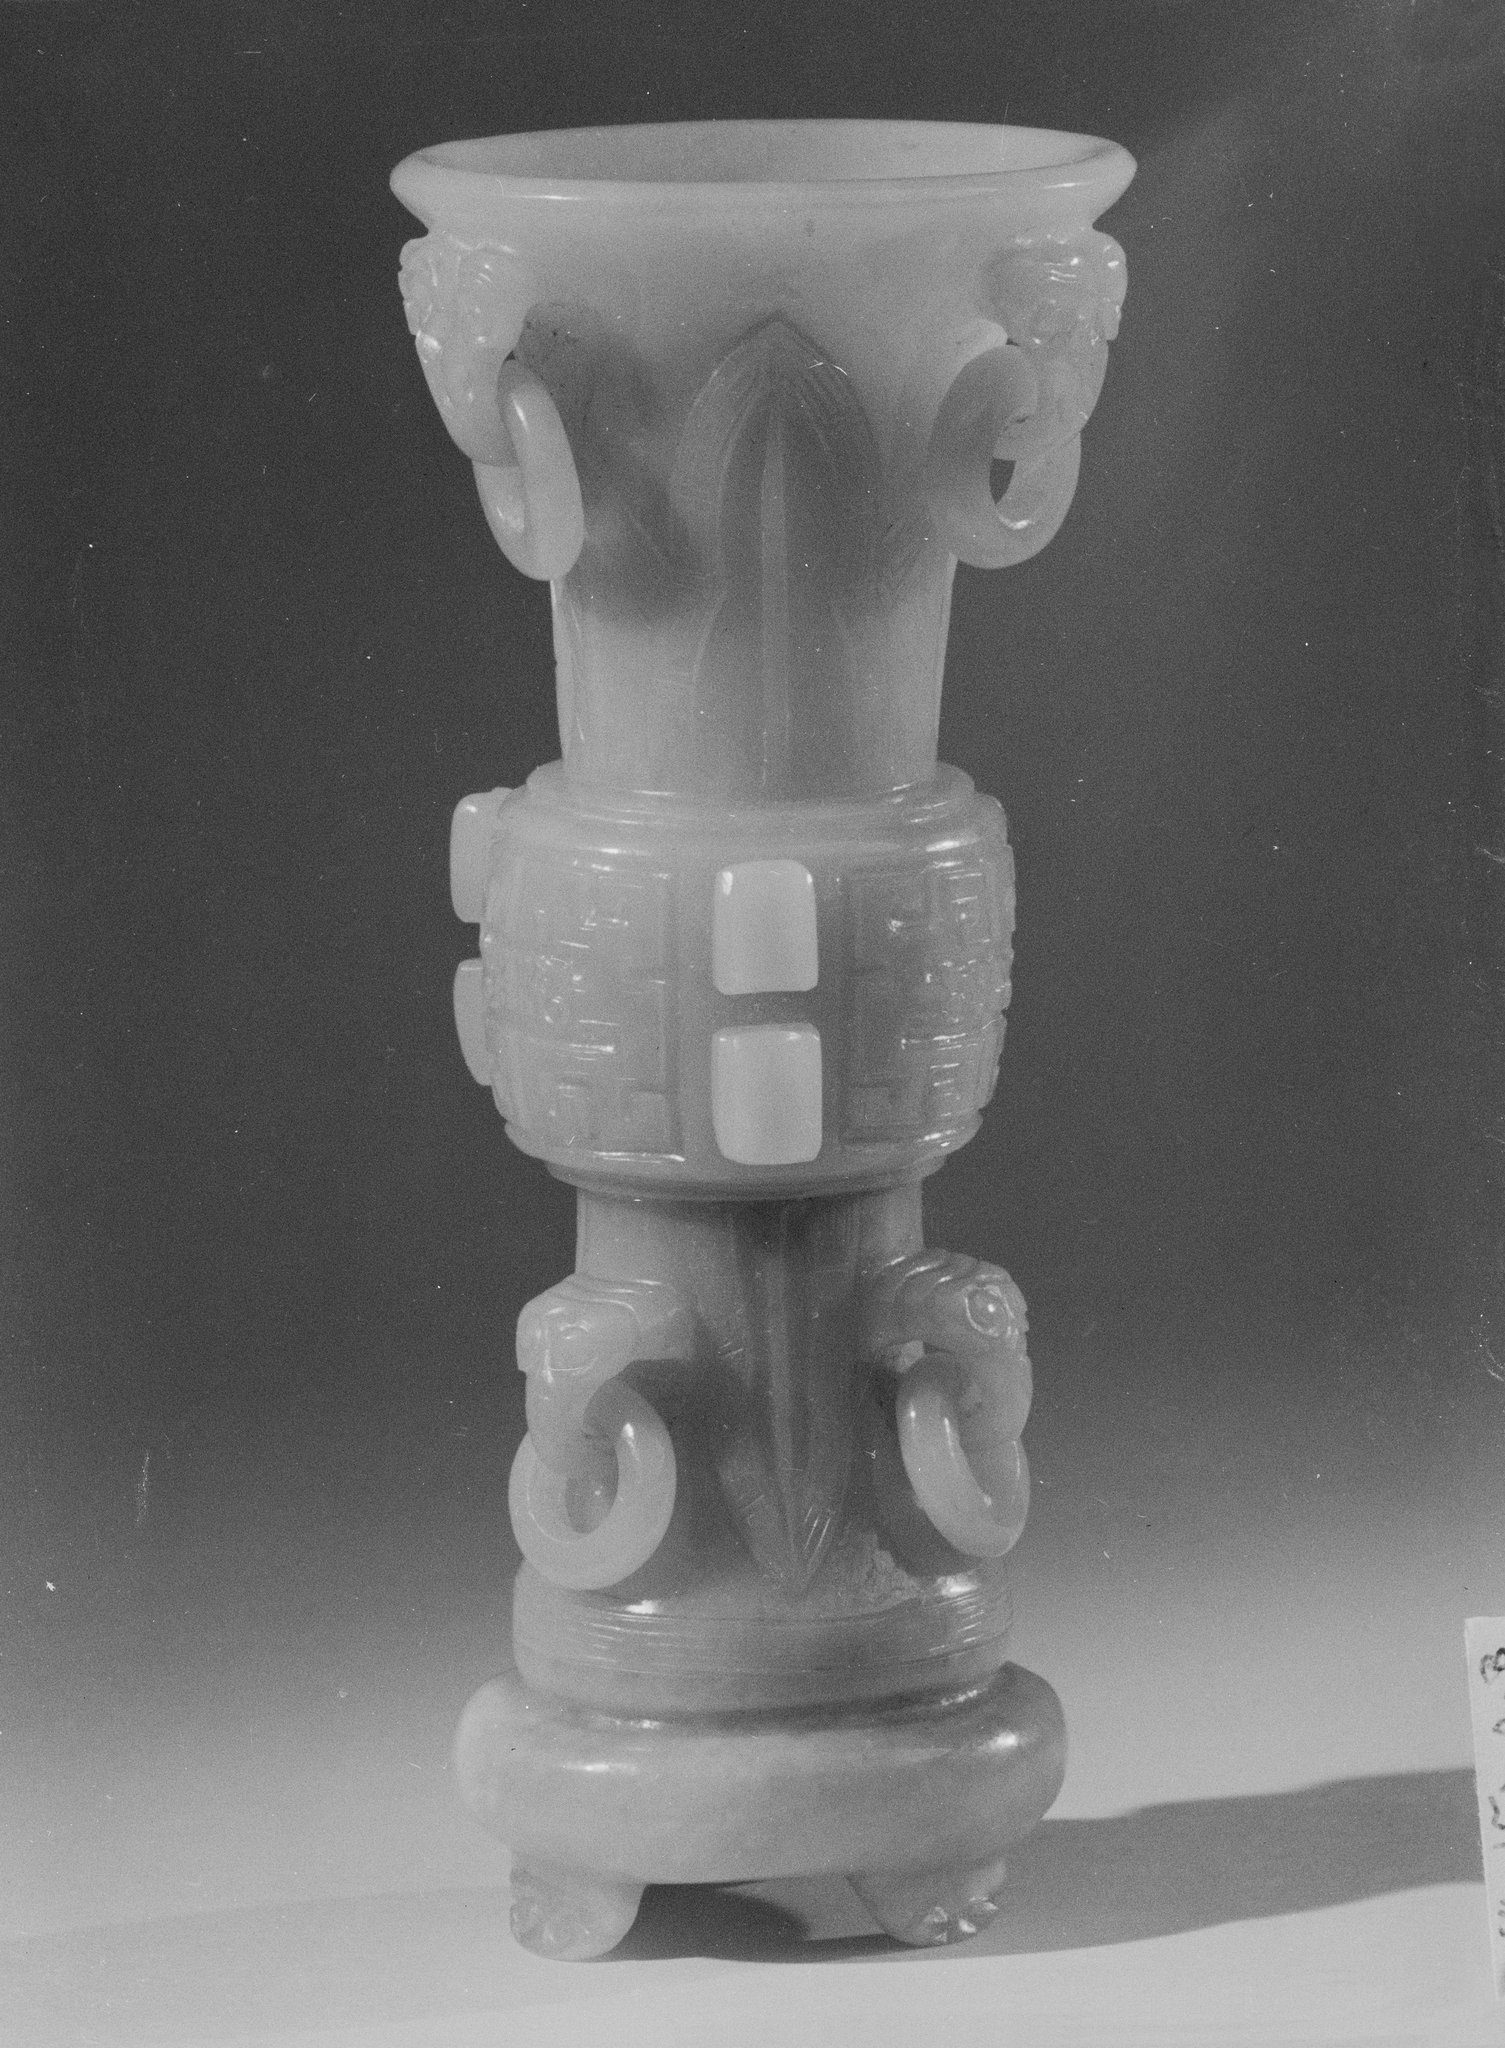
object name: vase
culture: chinese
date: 1801-1900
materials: jade